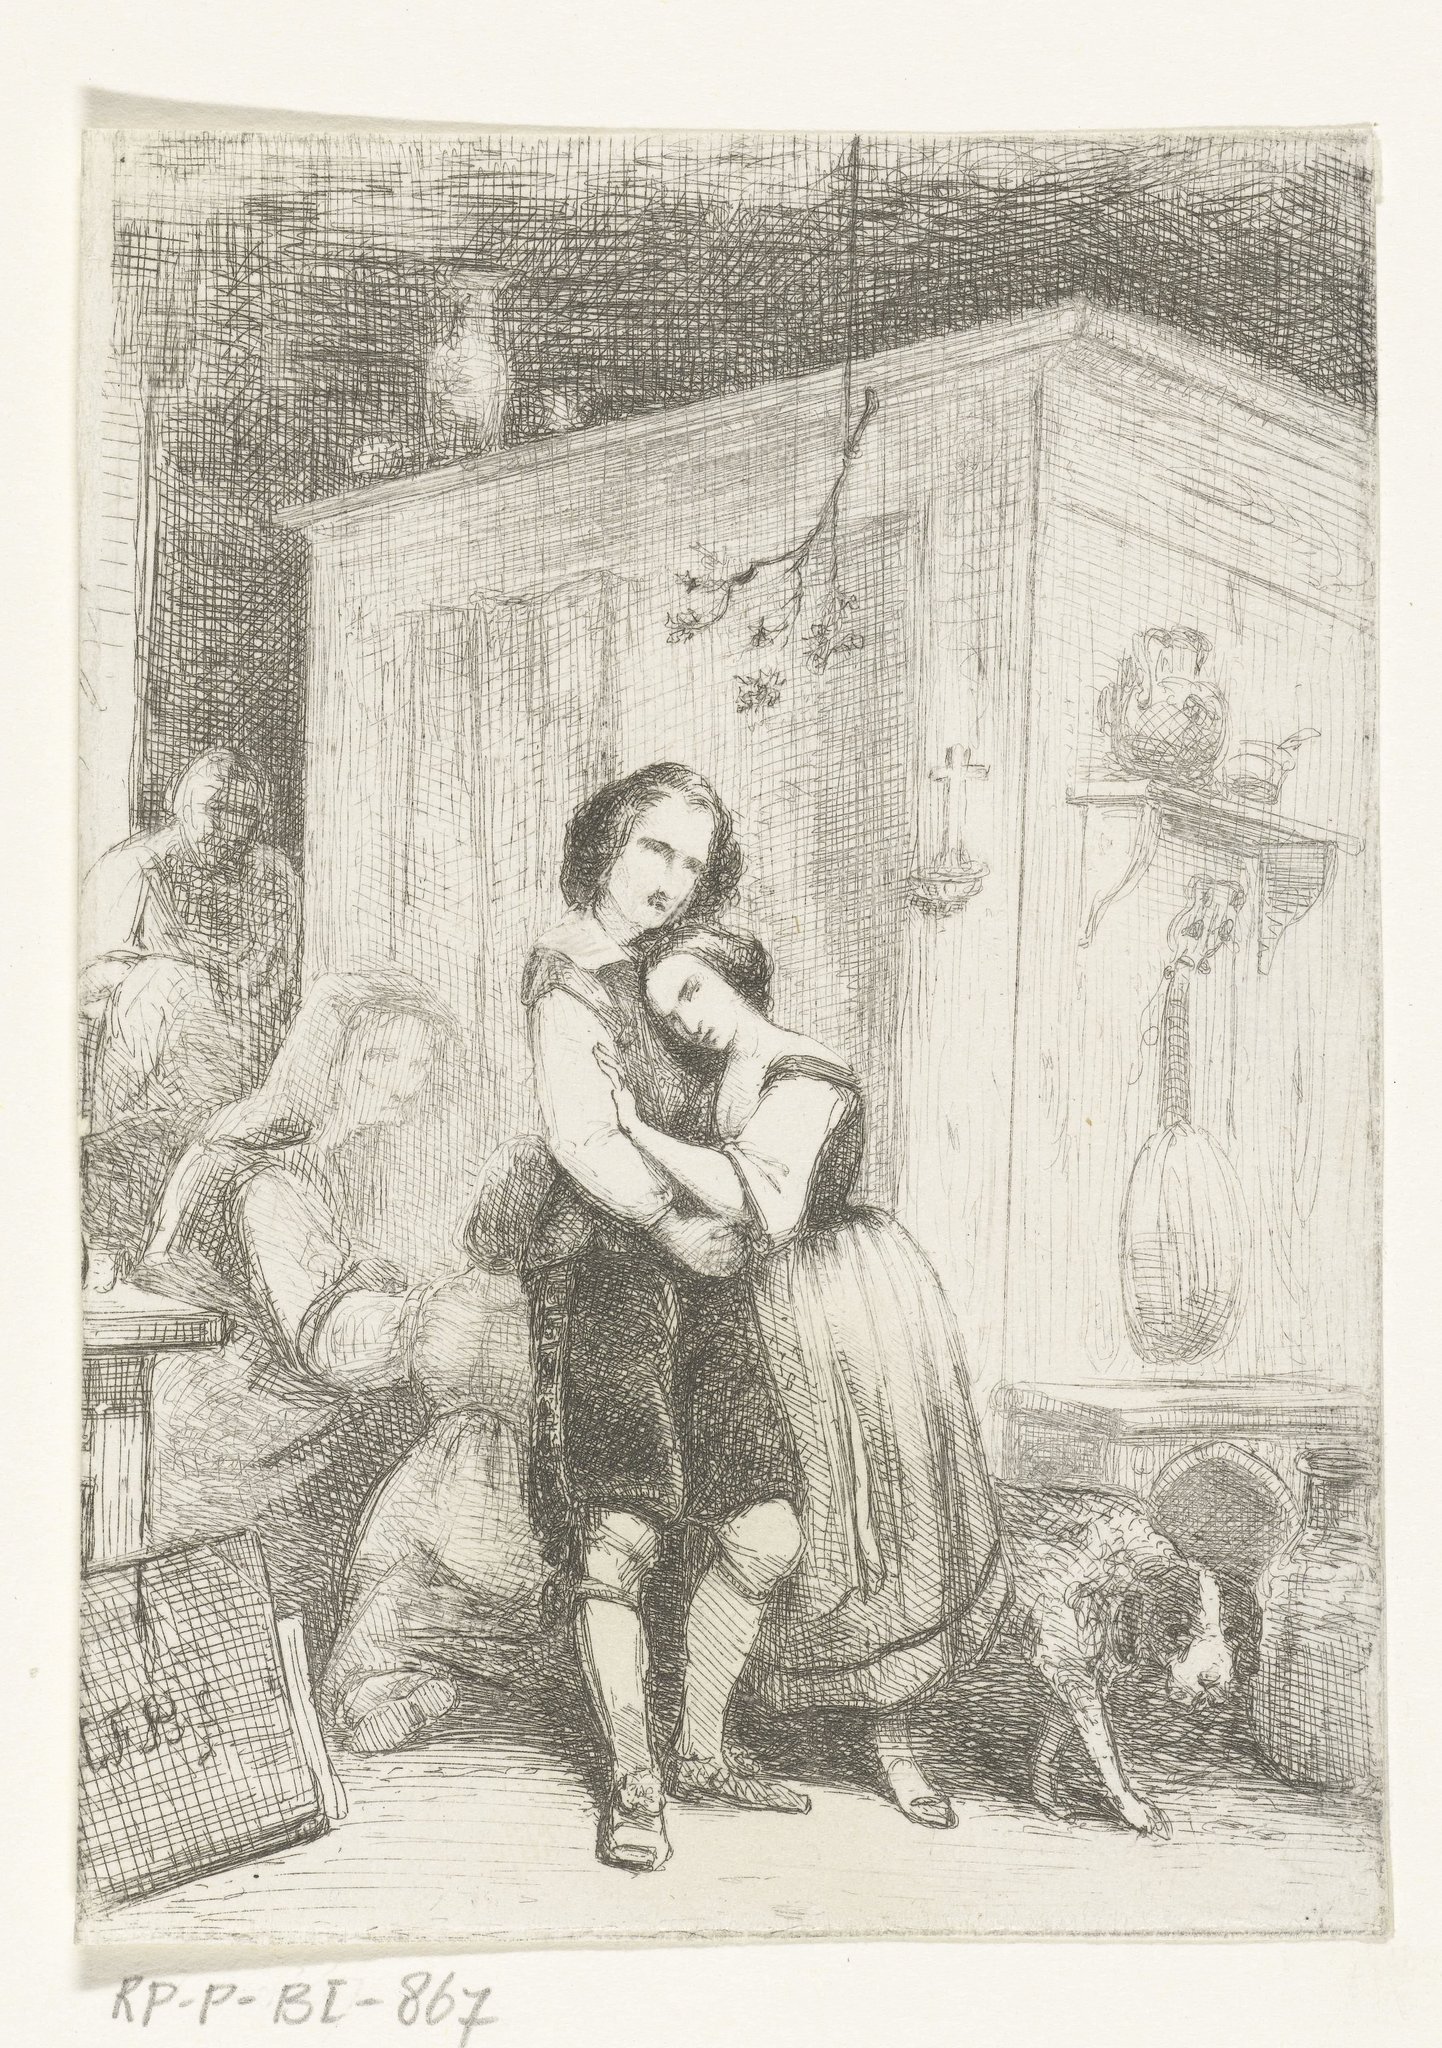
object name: print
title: Interieur met oude zieke vrouw en haar familie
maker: carel frederik bendorp (ii)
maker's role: draughtsman, painter, print maker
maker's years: 1819-1897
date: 1829-1897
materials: paper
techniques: etching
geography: netherlands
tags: family group, especially parents with their child(ren), patient, sick person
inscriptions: collector's mark: Lugt 2228